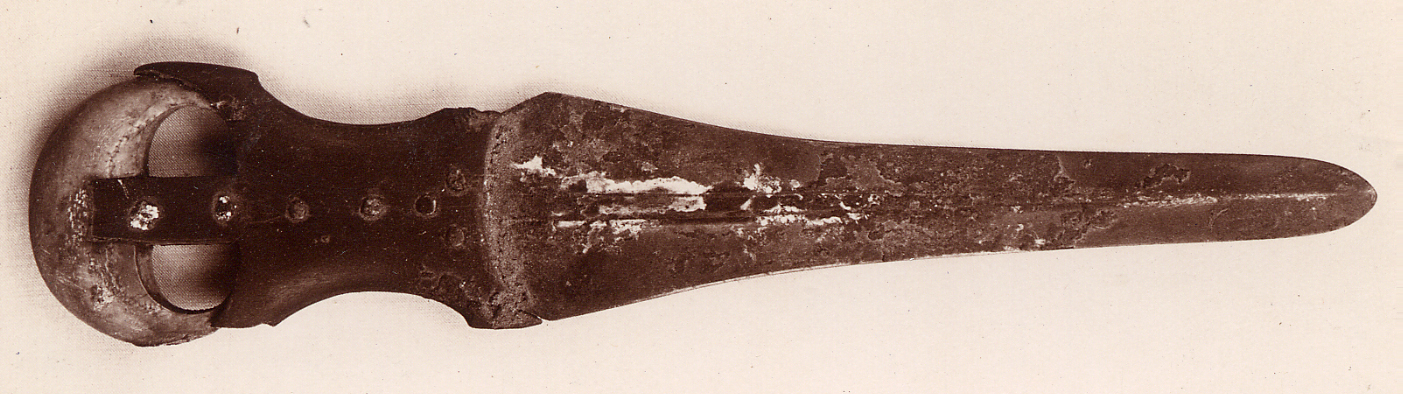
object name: dagger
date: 1981-1550 BCE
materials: bronze, copper alloy, ivory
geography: egypt